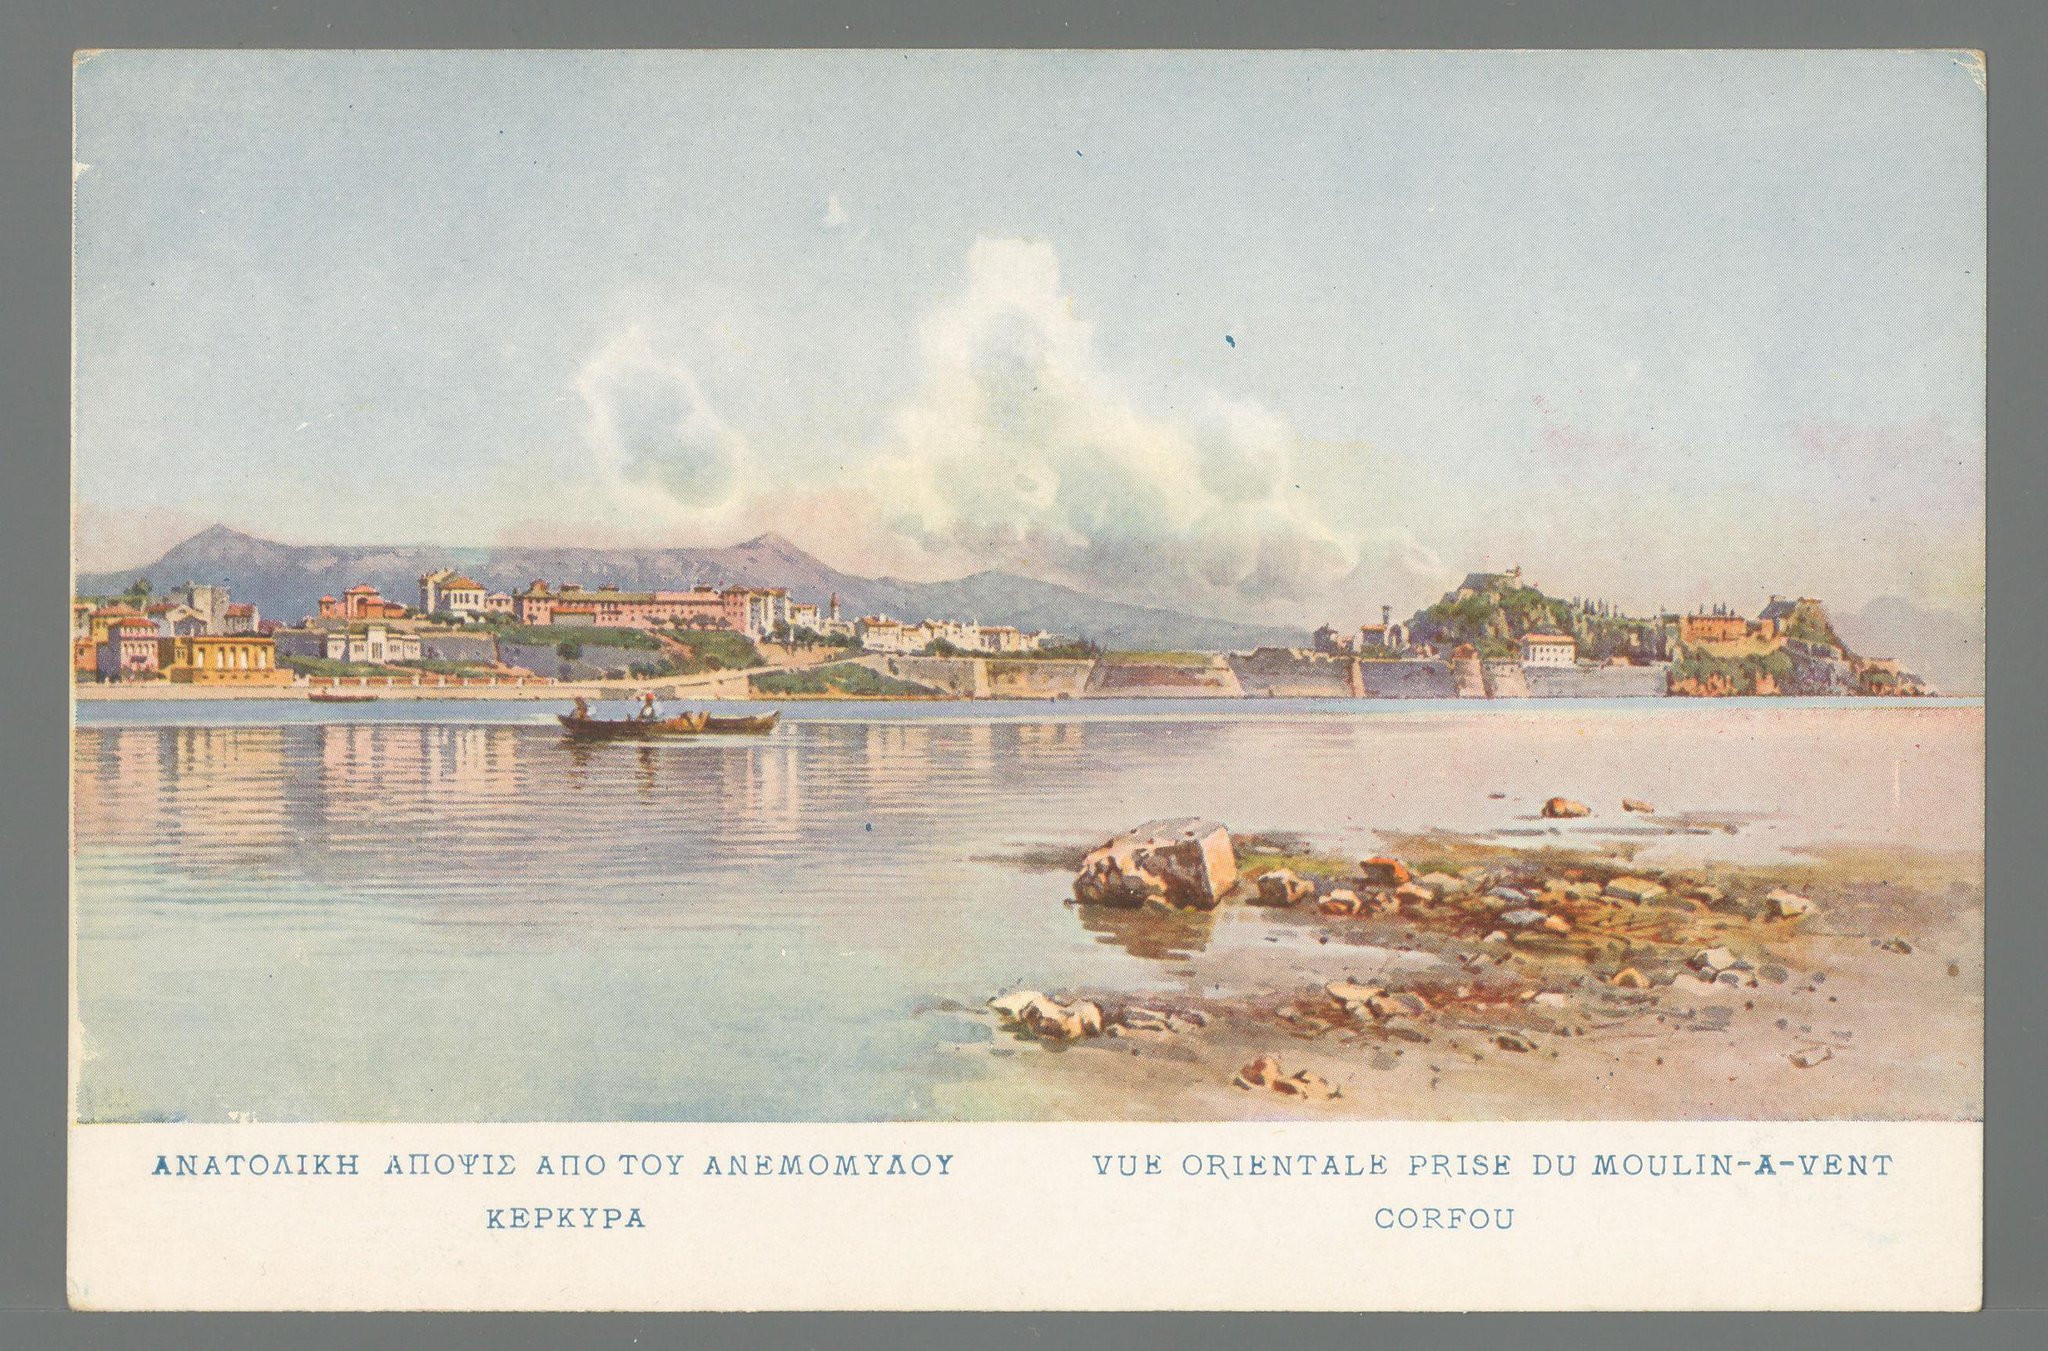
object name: reproduction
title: Vue orientale prise du moulin-a-vent. Corfou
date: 1906-1909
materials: cardboard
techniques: writing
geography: corfu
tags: island, sea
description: Voor de Franse titel staat de titel in het Grieks.